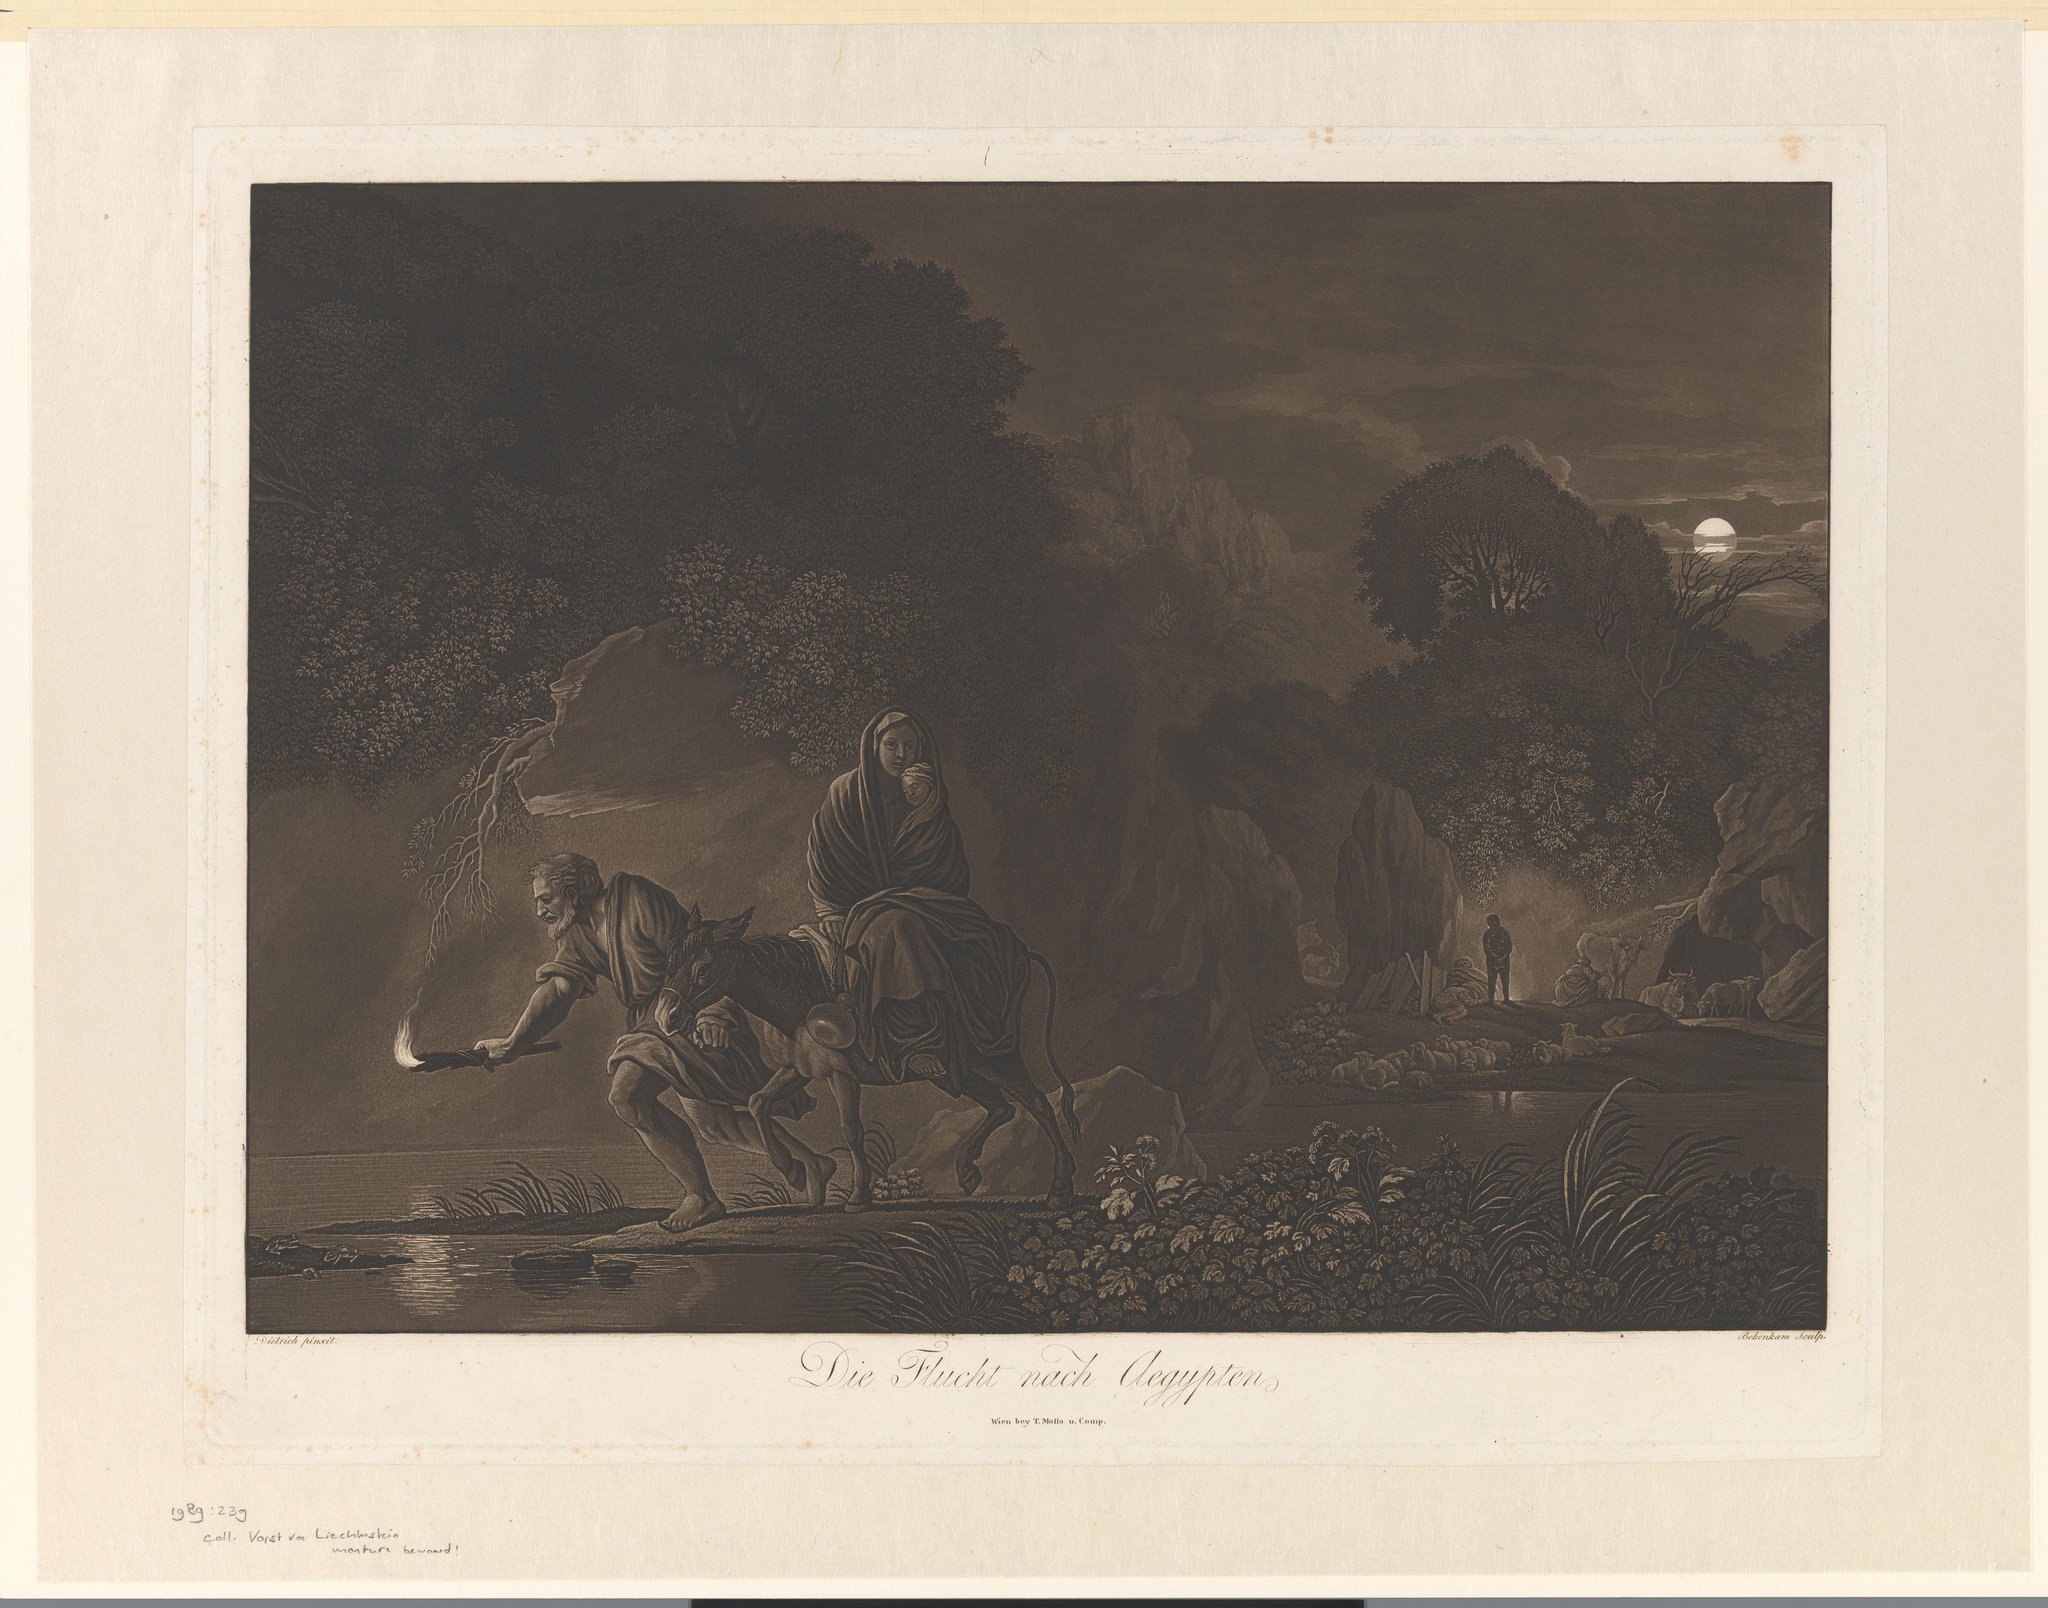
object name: print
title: Vlucht naar Egypte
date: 1768-1849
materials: paper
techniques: aquatint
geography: vienna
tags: the flight into egypt: mary, joseph, the child (and sometimes others) on their way; mary usually riding on an ass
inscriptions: collector's mark: Lugt 2228, collector's mark: Lugt 2760